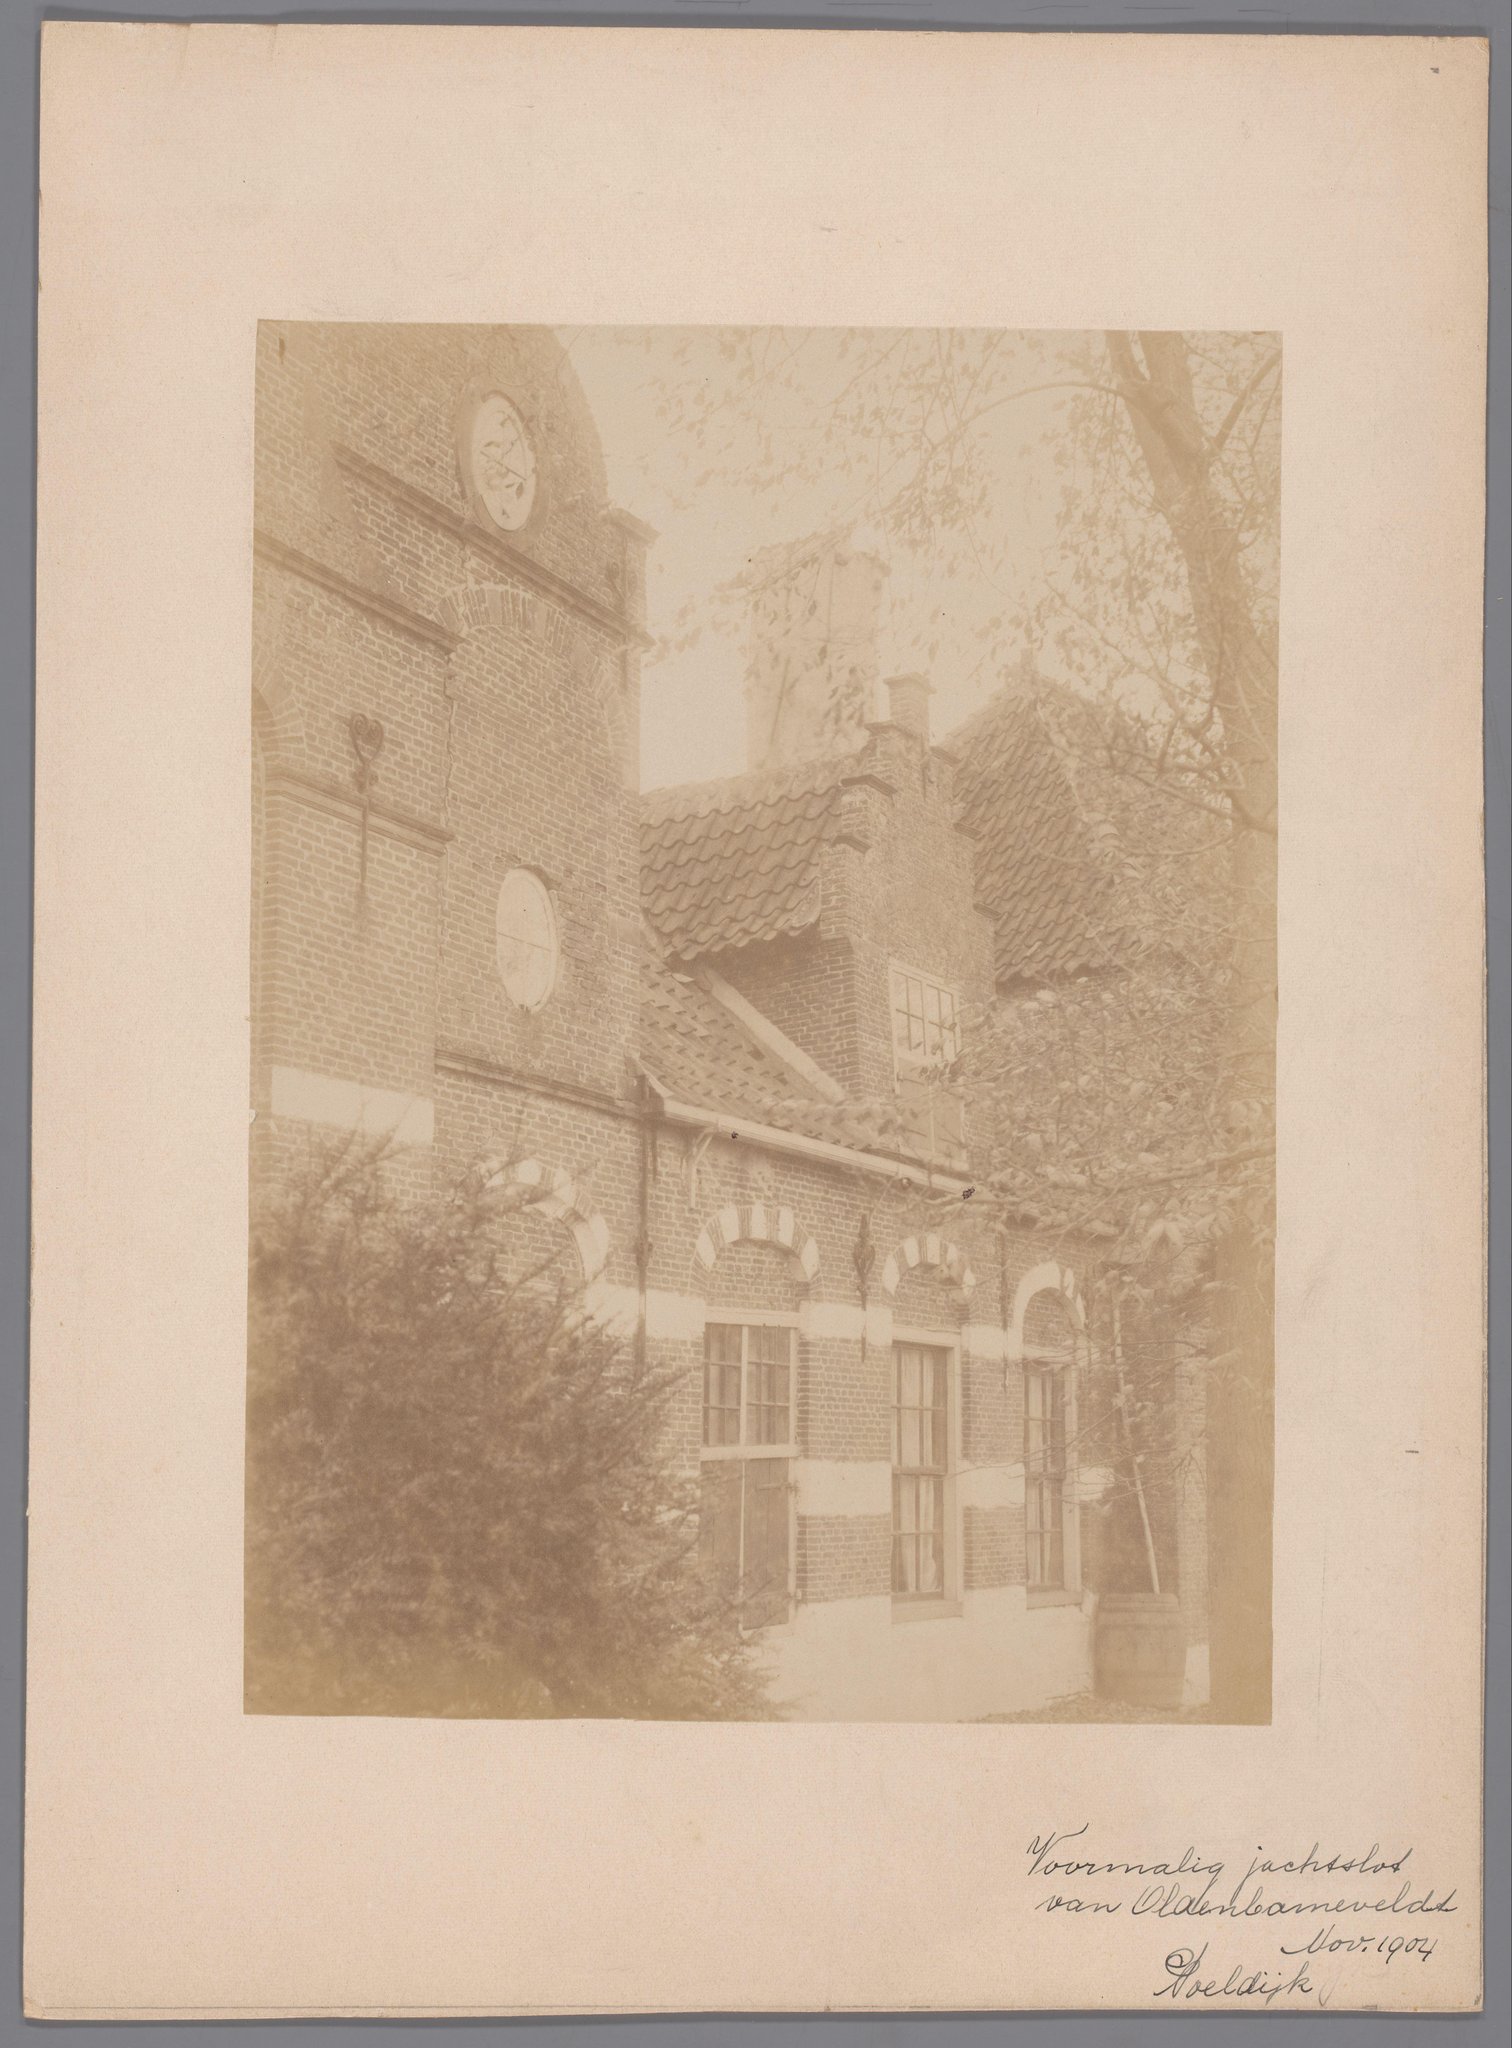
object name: photograph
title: Façade van het voormalige jachtslot van Oldenbarnevelt of Torenzicht te Poeldijk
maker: anoniem (monumentenzorg)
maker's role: fotograaf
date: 1904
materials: cardboard, photographic support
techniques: albumen print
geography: poeldijk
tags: castle, façade (of house or building)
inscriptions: annotation: ‘Voormalig jachtslot van Oldenbarneveldt/ Nov. 1904/ Poeldijk’, annotation: ‘Poeldijk (Z.H.)/ Torenzicht/ Voormalig jachtslot van Oldenbarneveldt/ Nov 1904’